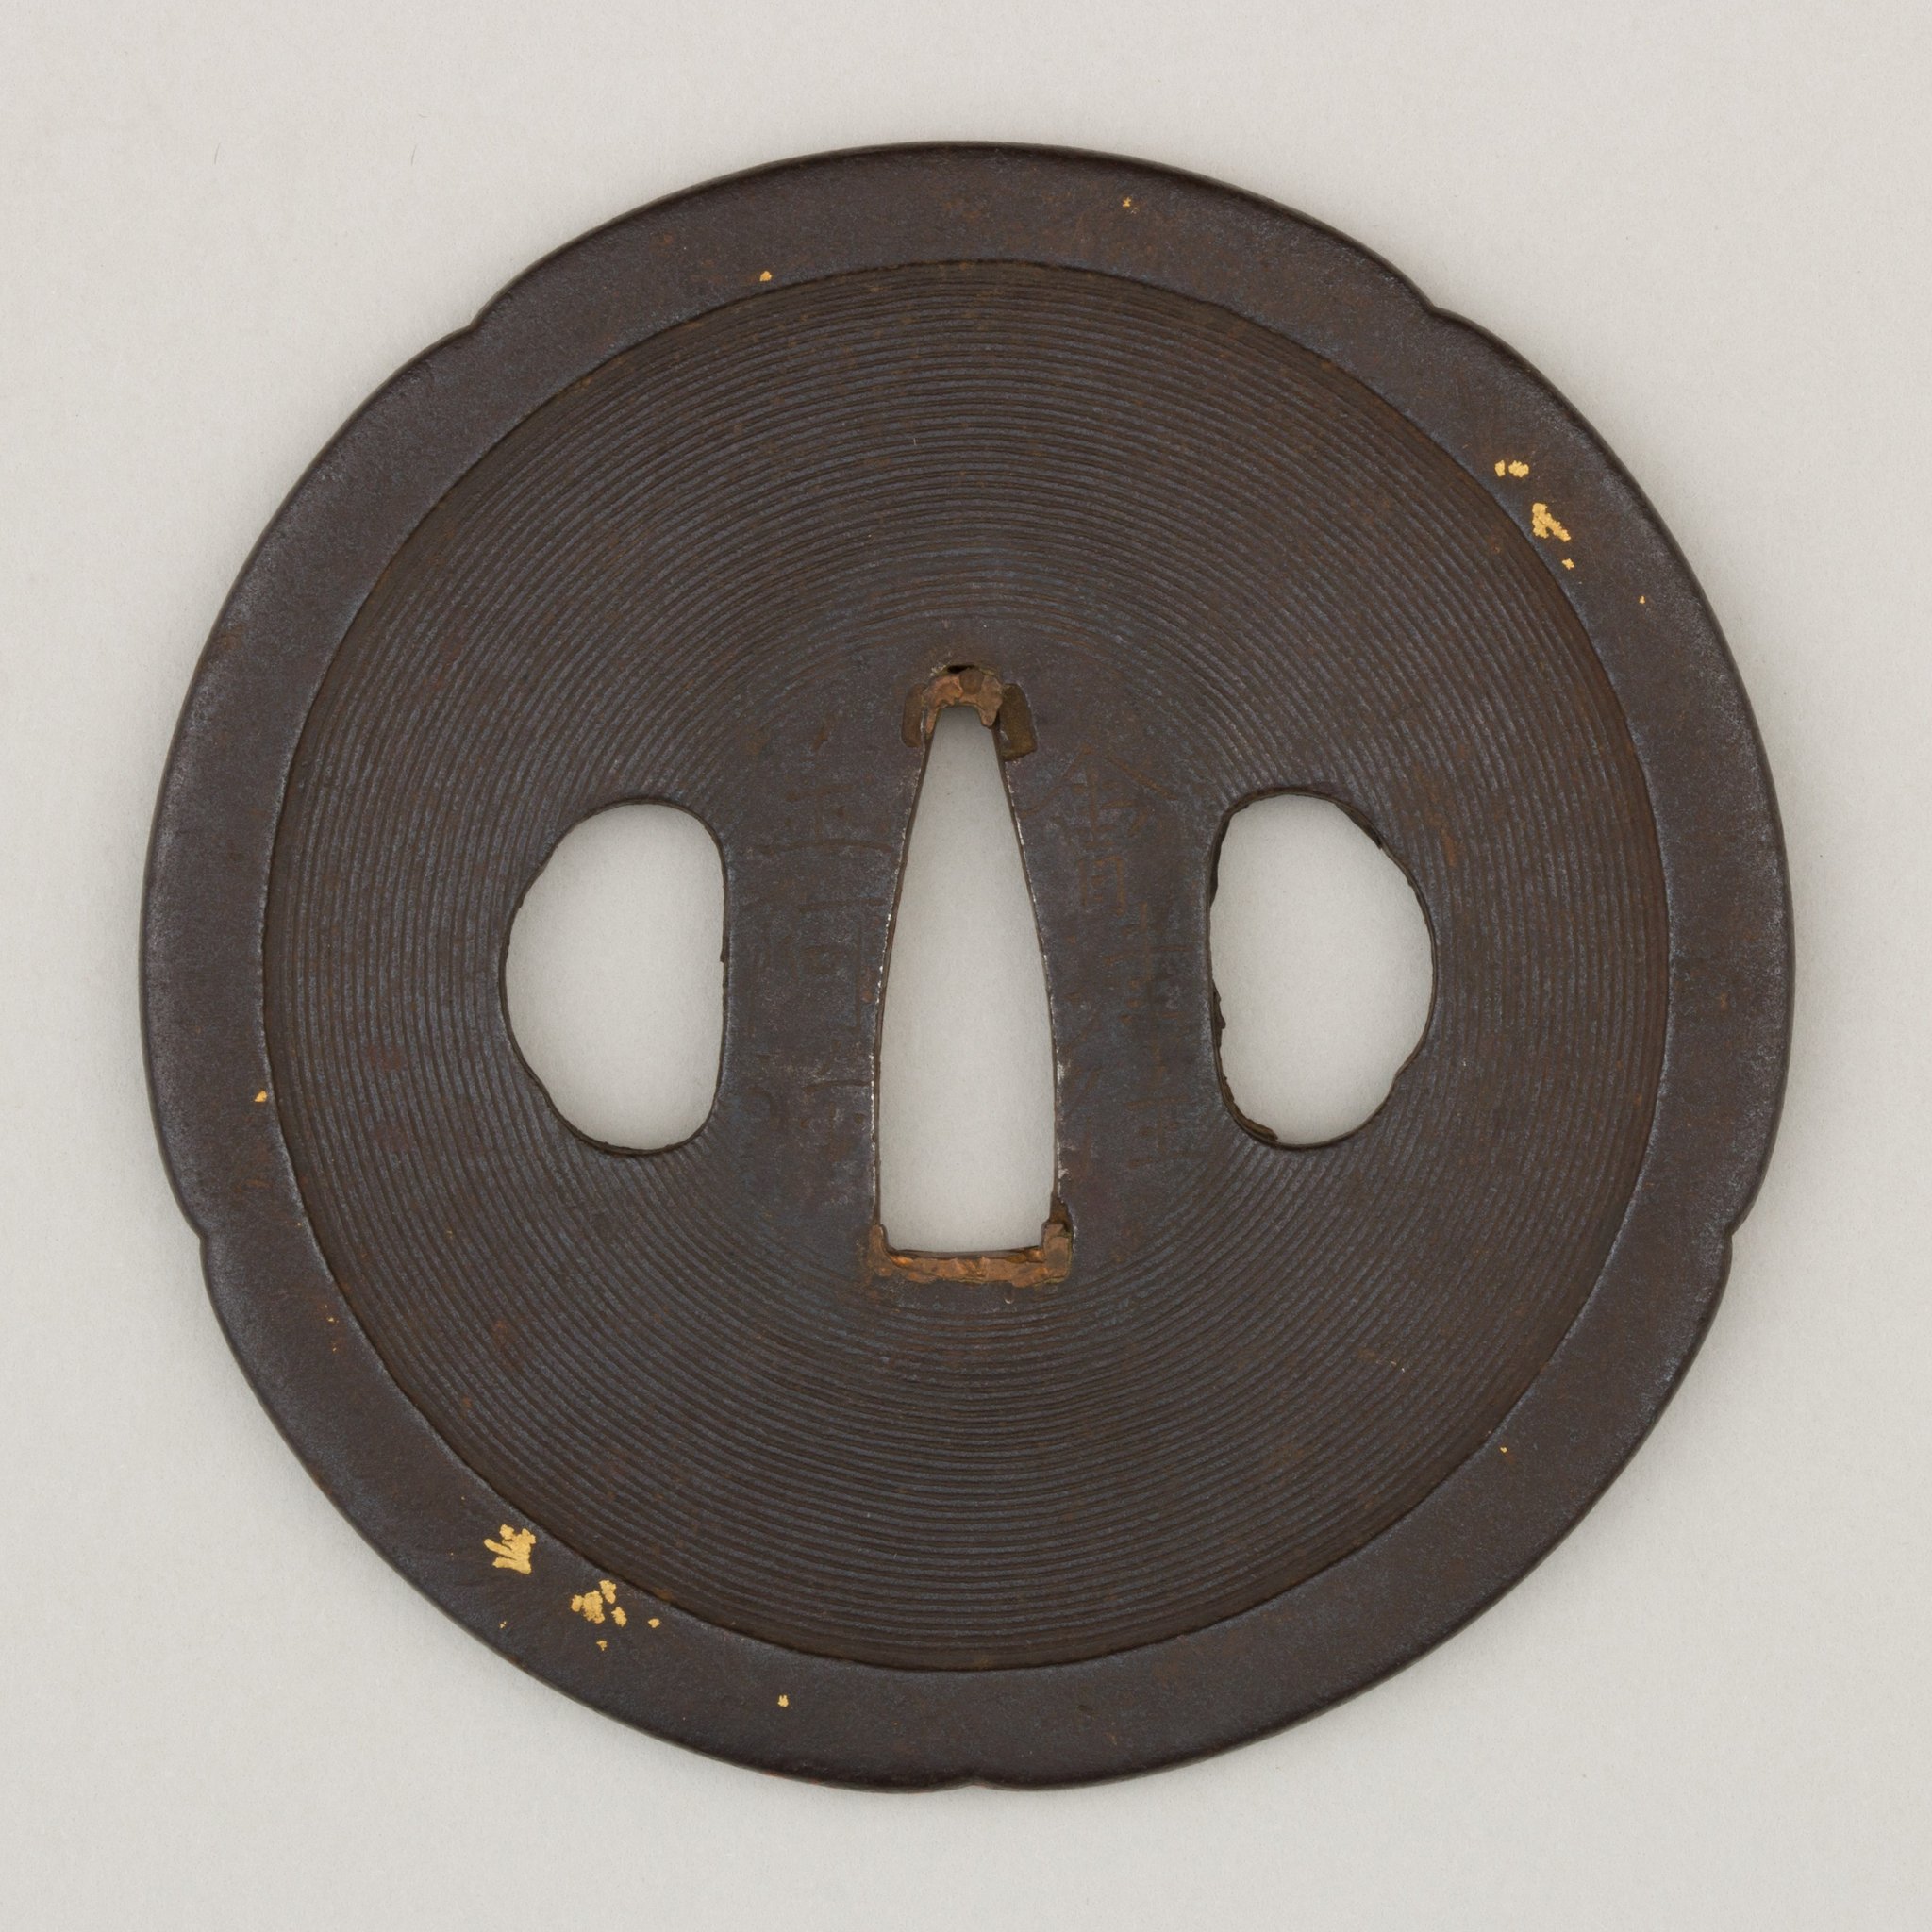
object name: sword guard tsuba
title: Sword Guard (Tsuba)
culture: japanese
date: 1667-1700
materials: copper, iron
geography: japan